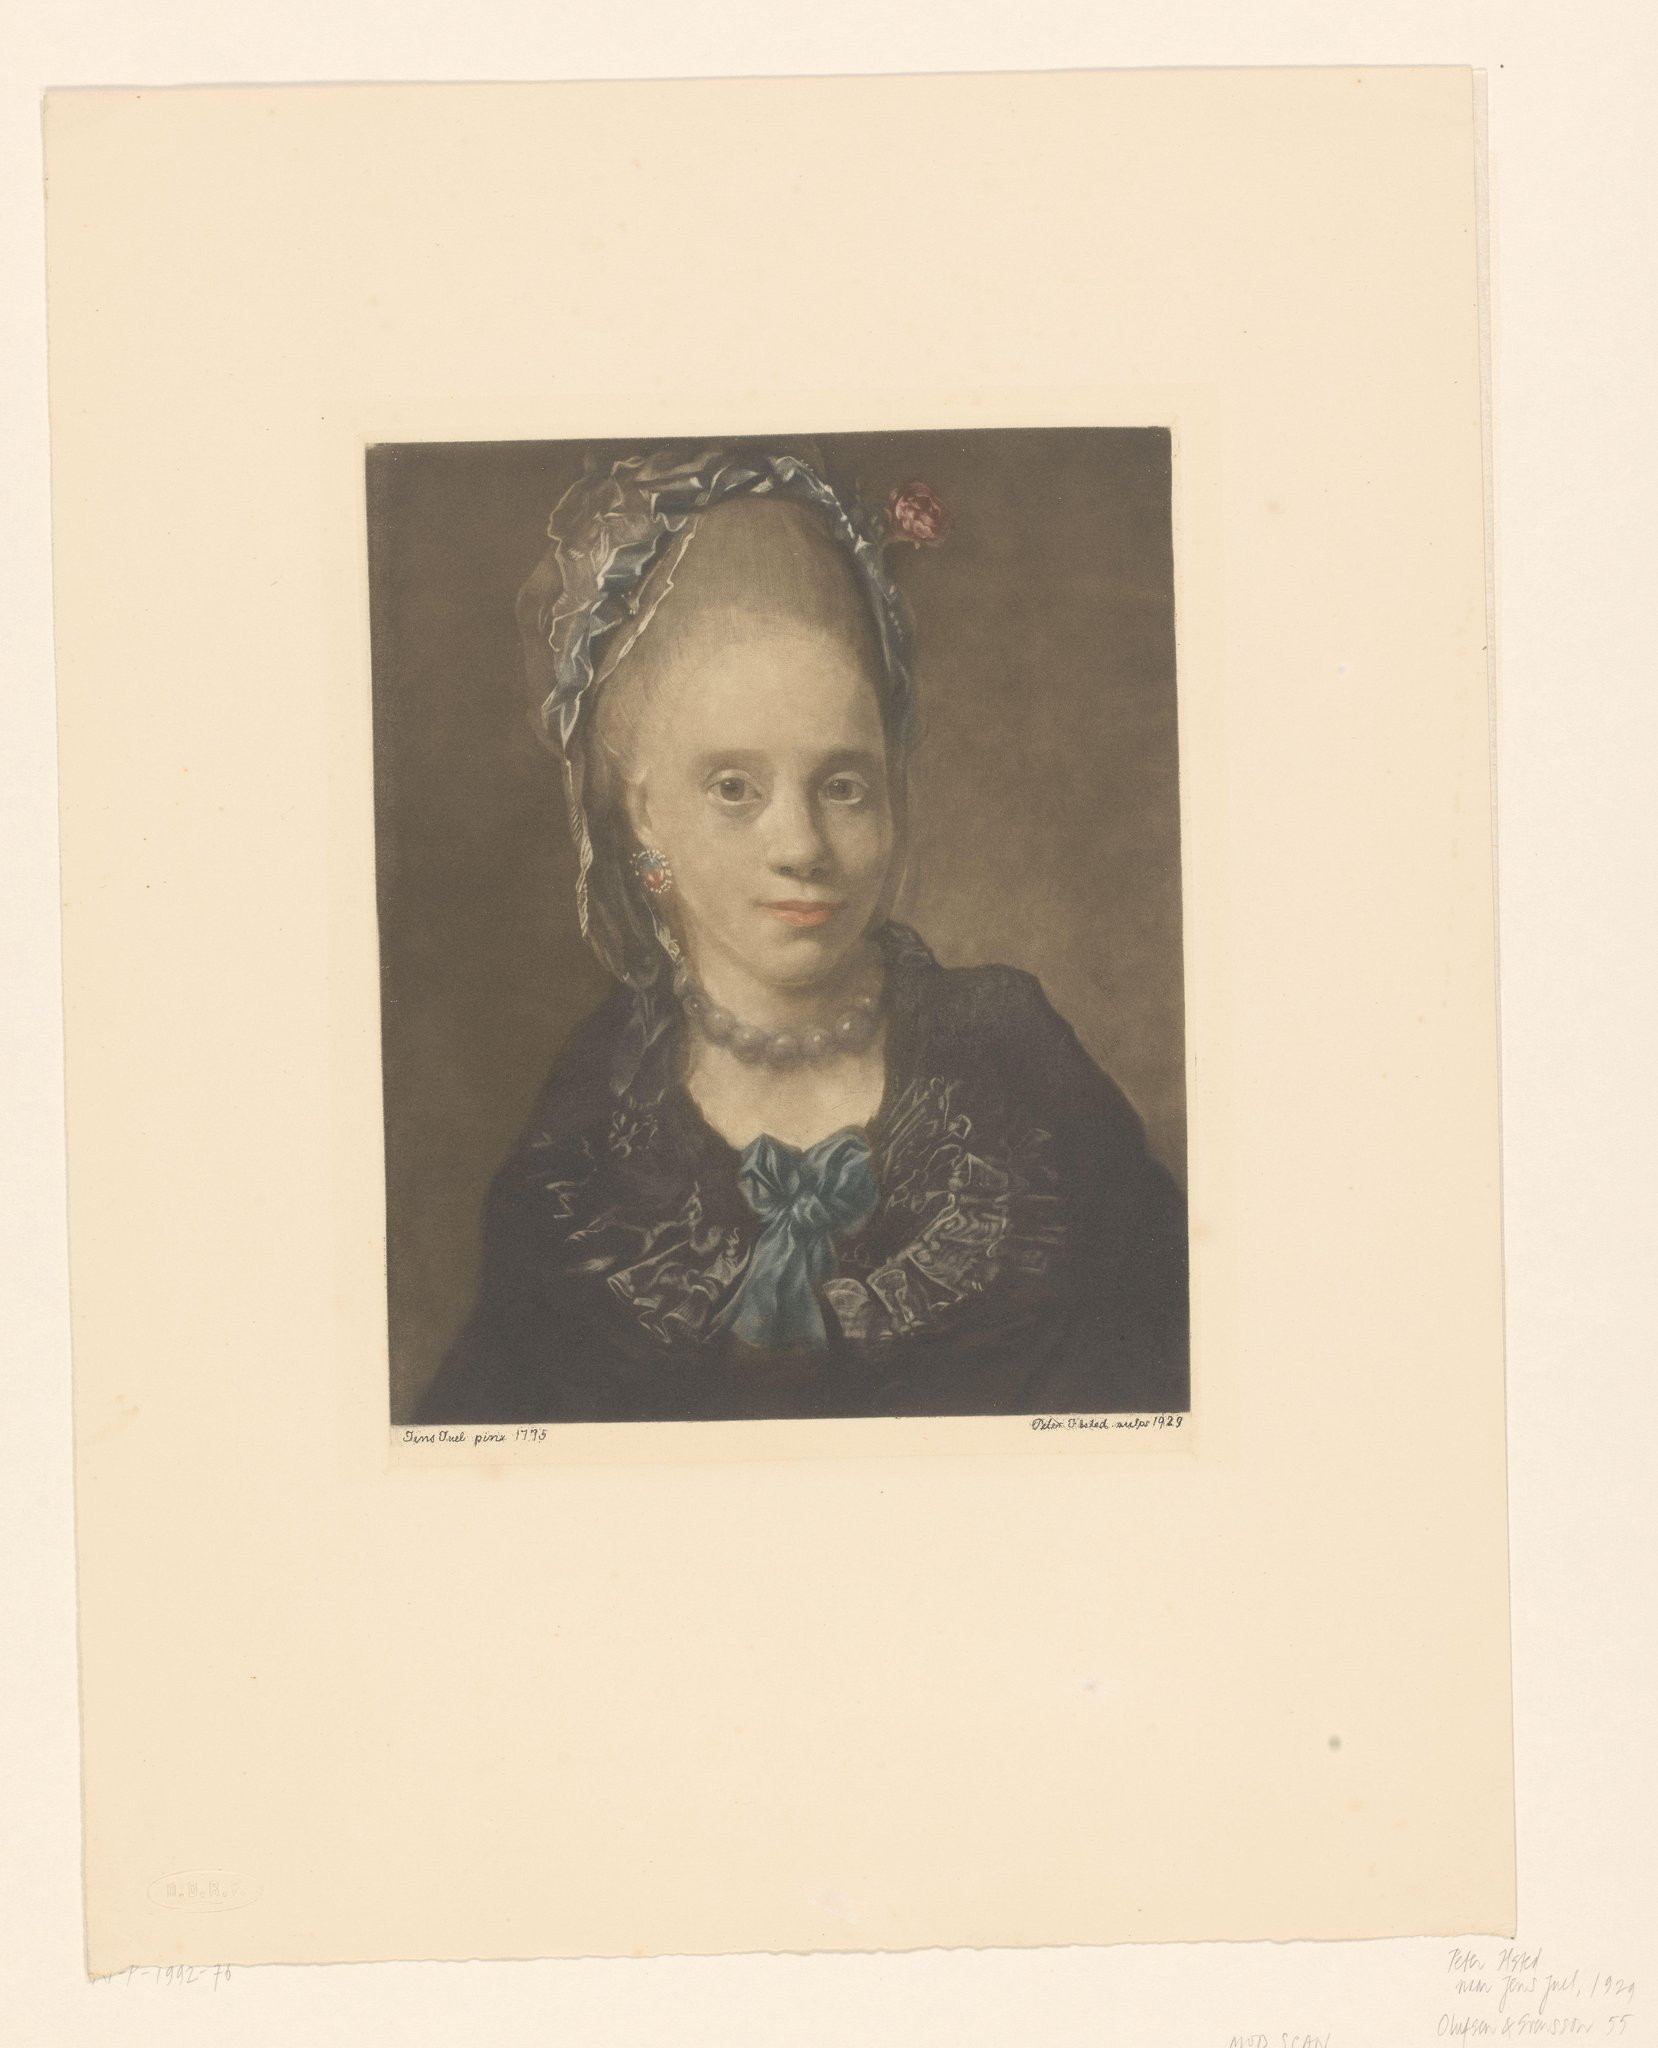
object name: print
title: Portret van een dame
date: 1929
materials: paper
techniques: color mezzotint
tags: adolescent, young woman, maiden, anonymous historical person portrayed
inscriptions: collector's mark: Lugt 2228, check stamp: ‘D.D.R.F.’, collector's mark: Lugt 2760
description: Portret van een jonge vrouw, van voren gezien. Ze draagt een donkere mantel met satijnen kraag, afgezet met een blauwe strik; op haar hoofd een kanten doek.